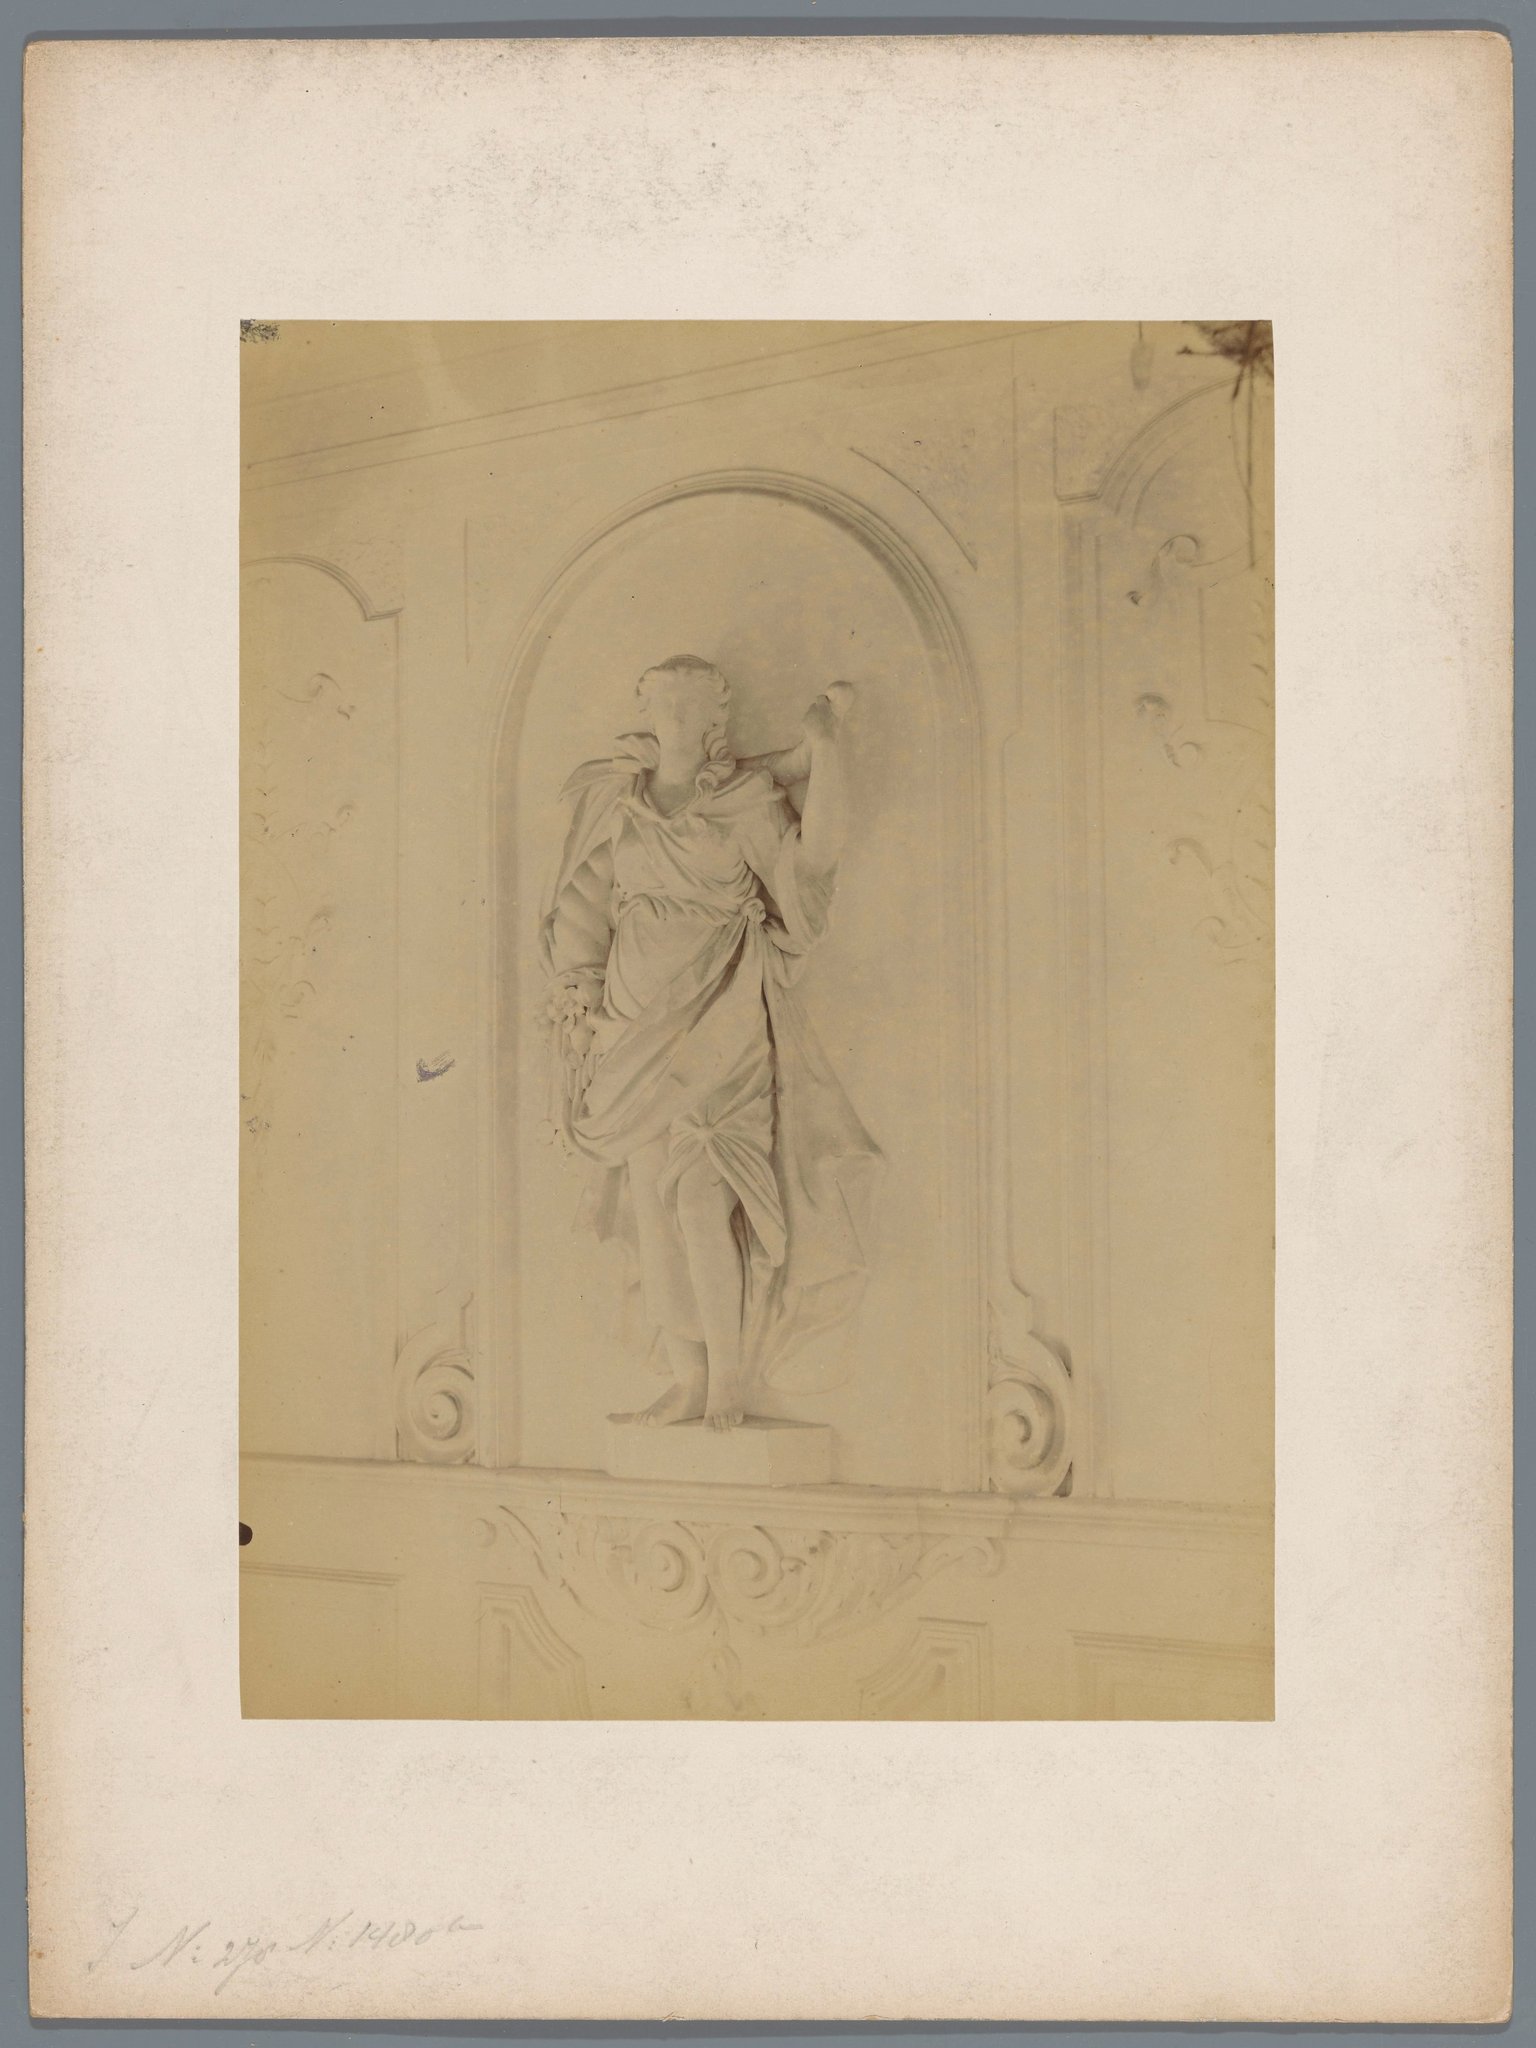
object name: photograph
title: Stuccobeeld in het trappenhuis van Huis ter Meer te Maarssen, voorstellende een vrouw met de Hoorn des overvloeds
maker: Anonymous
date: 1875-1900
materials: cardboard, photographic support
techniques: albumen print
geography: huis ter meer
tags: 'cornucopia', horn of plenty, sculpture, interior ~ representation of a building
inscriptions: annotation, inscription: ‘neg. no 15963 foto 22309’, inscription: ‘Maarsen, U. Huis ,,ter Meer''. gesloopt Aug. 1903. Een der stuccobeelden in het trappenhuis.’